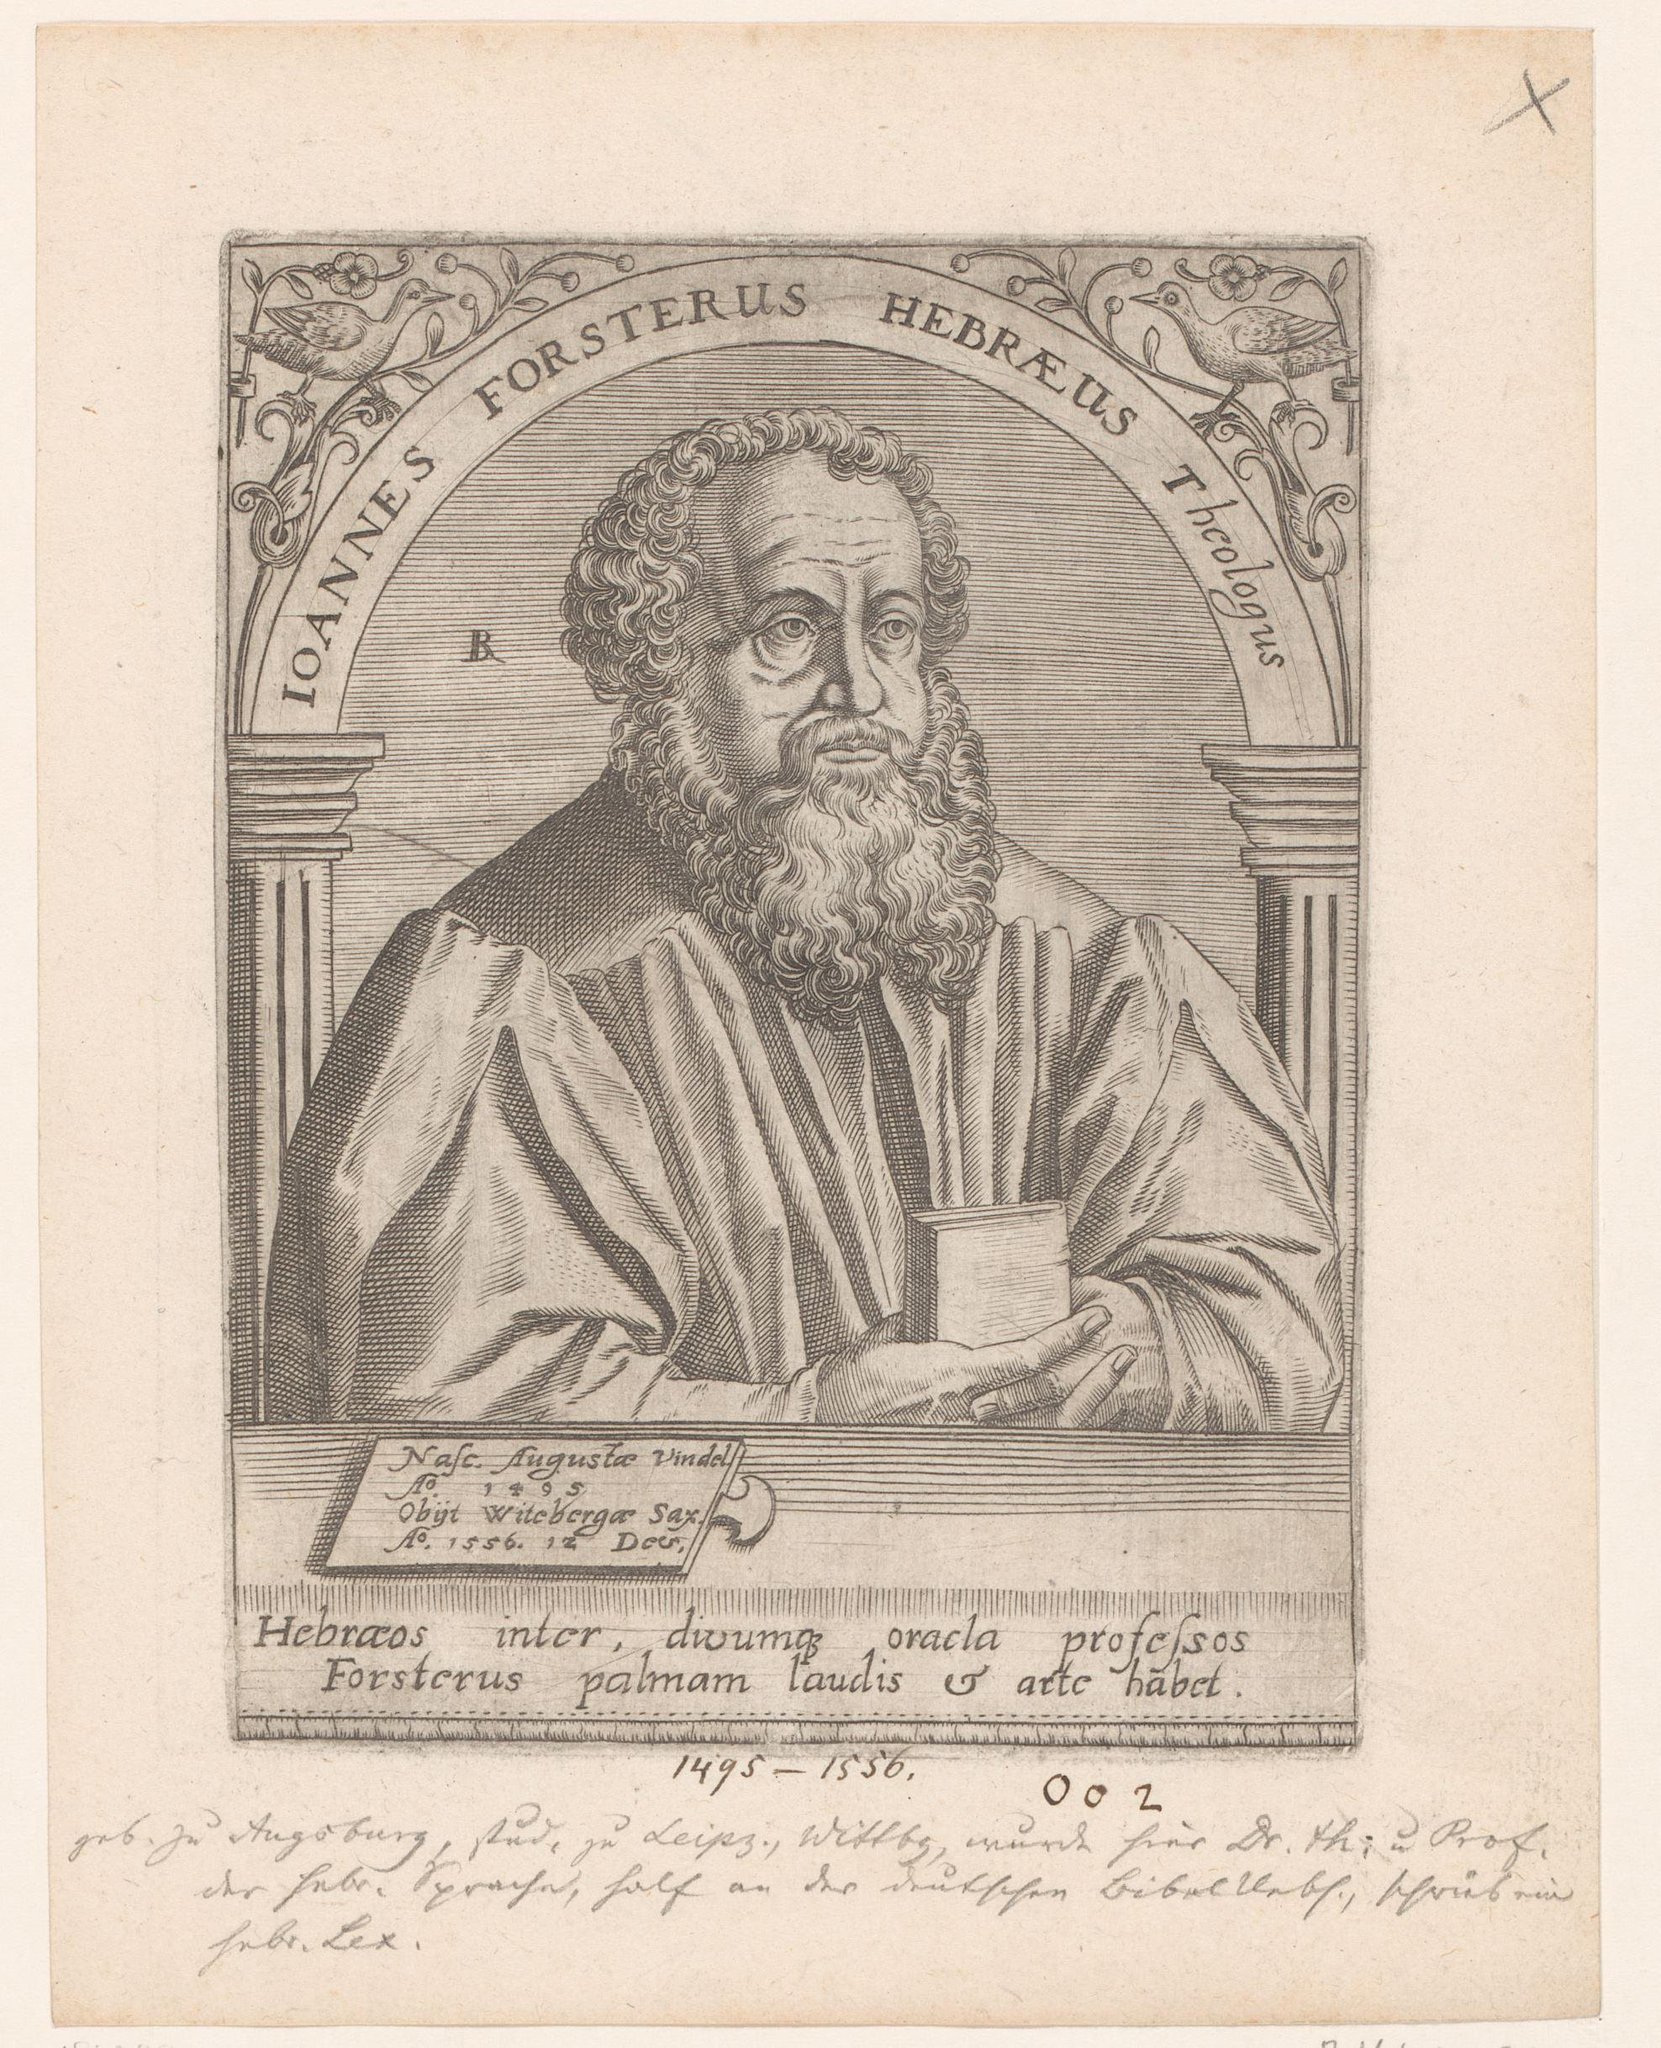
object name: print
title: Joannes Forsterus Hebraeus Theologus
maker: robert boissard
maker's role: print maker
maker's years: 1570-1611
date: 1597-1599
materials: paper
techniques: engraving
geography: france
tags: augsburg, historical persons, book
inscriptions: collector's mark: Lugt 2233, inscription: ‘Georgius Princeps Anbaldinus. Hic populi Princeps, simul est hic Pastor ejusdem. (...)’, inscription: ‘1495-1556. Oo2’